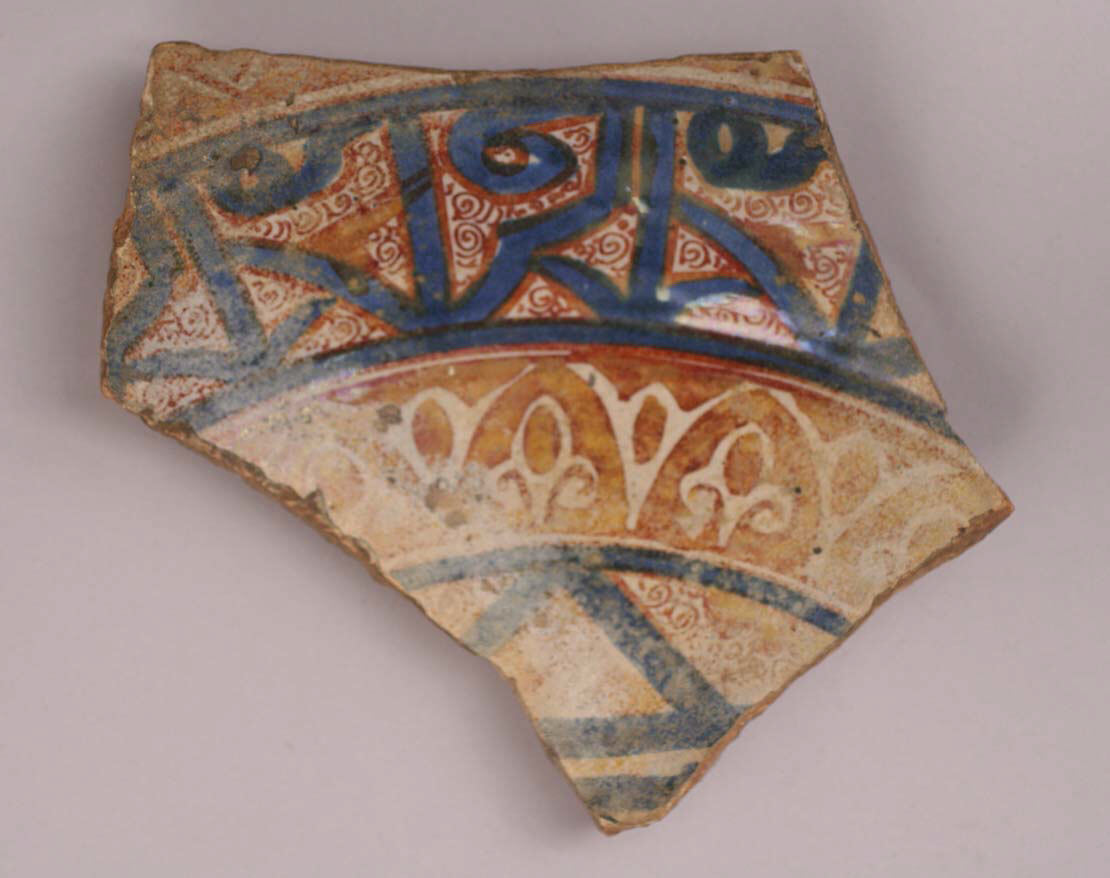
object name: fragment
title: Ceramic Fragment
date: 1401-1500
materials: earthenware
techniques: glazing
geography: spain